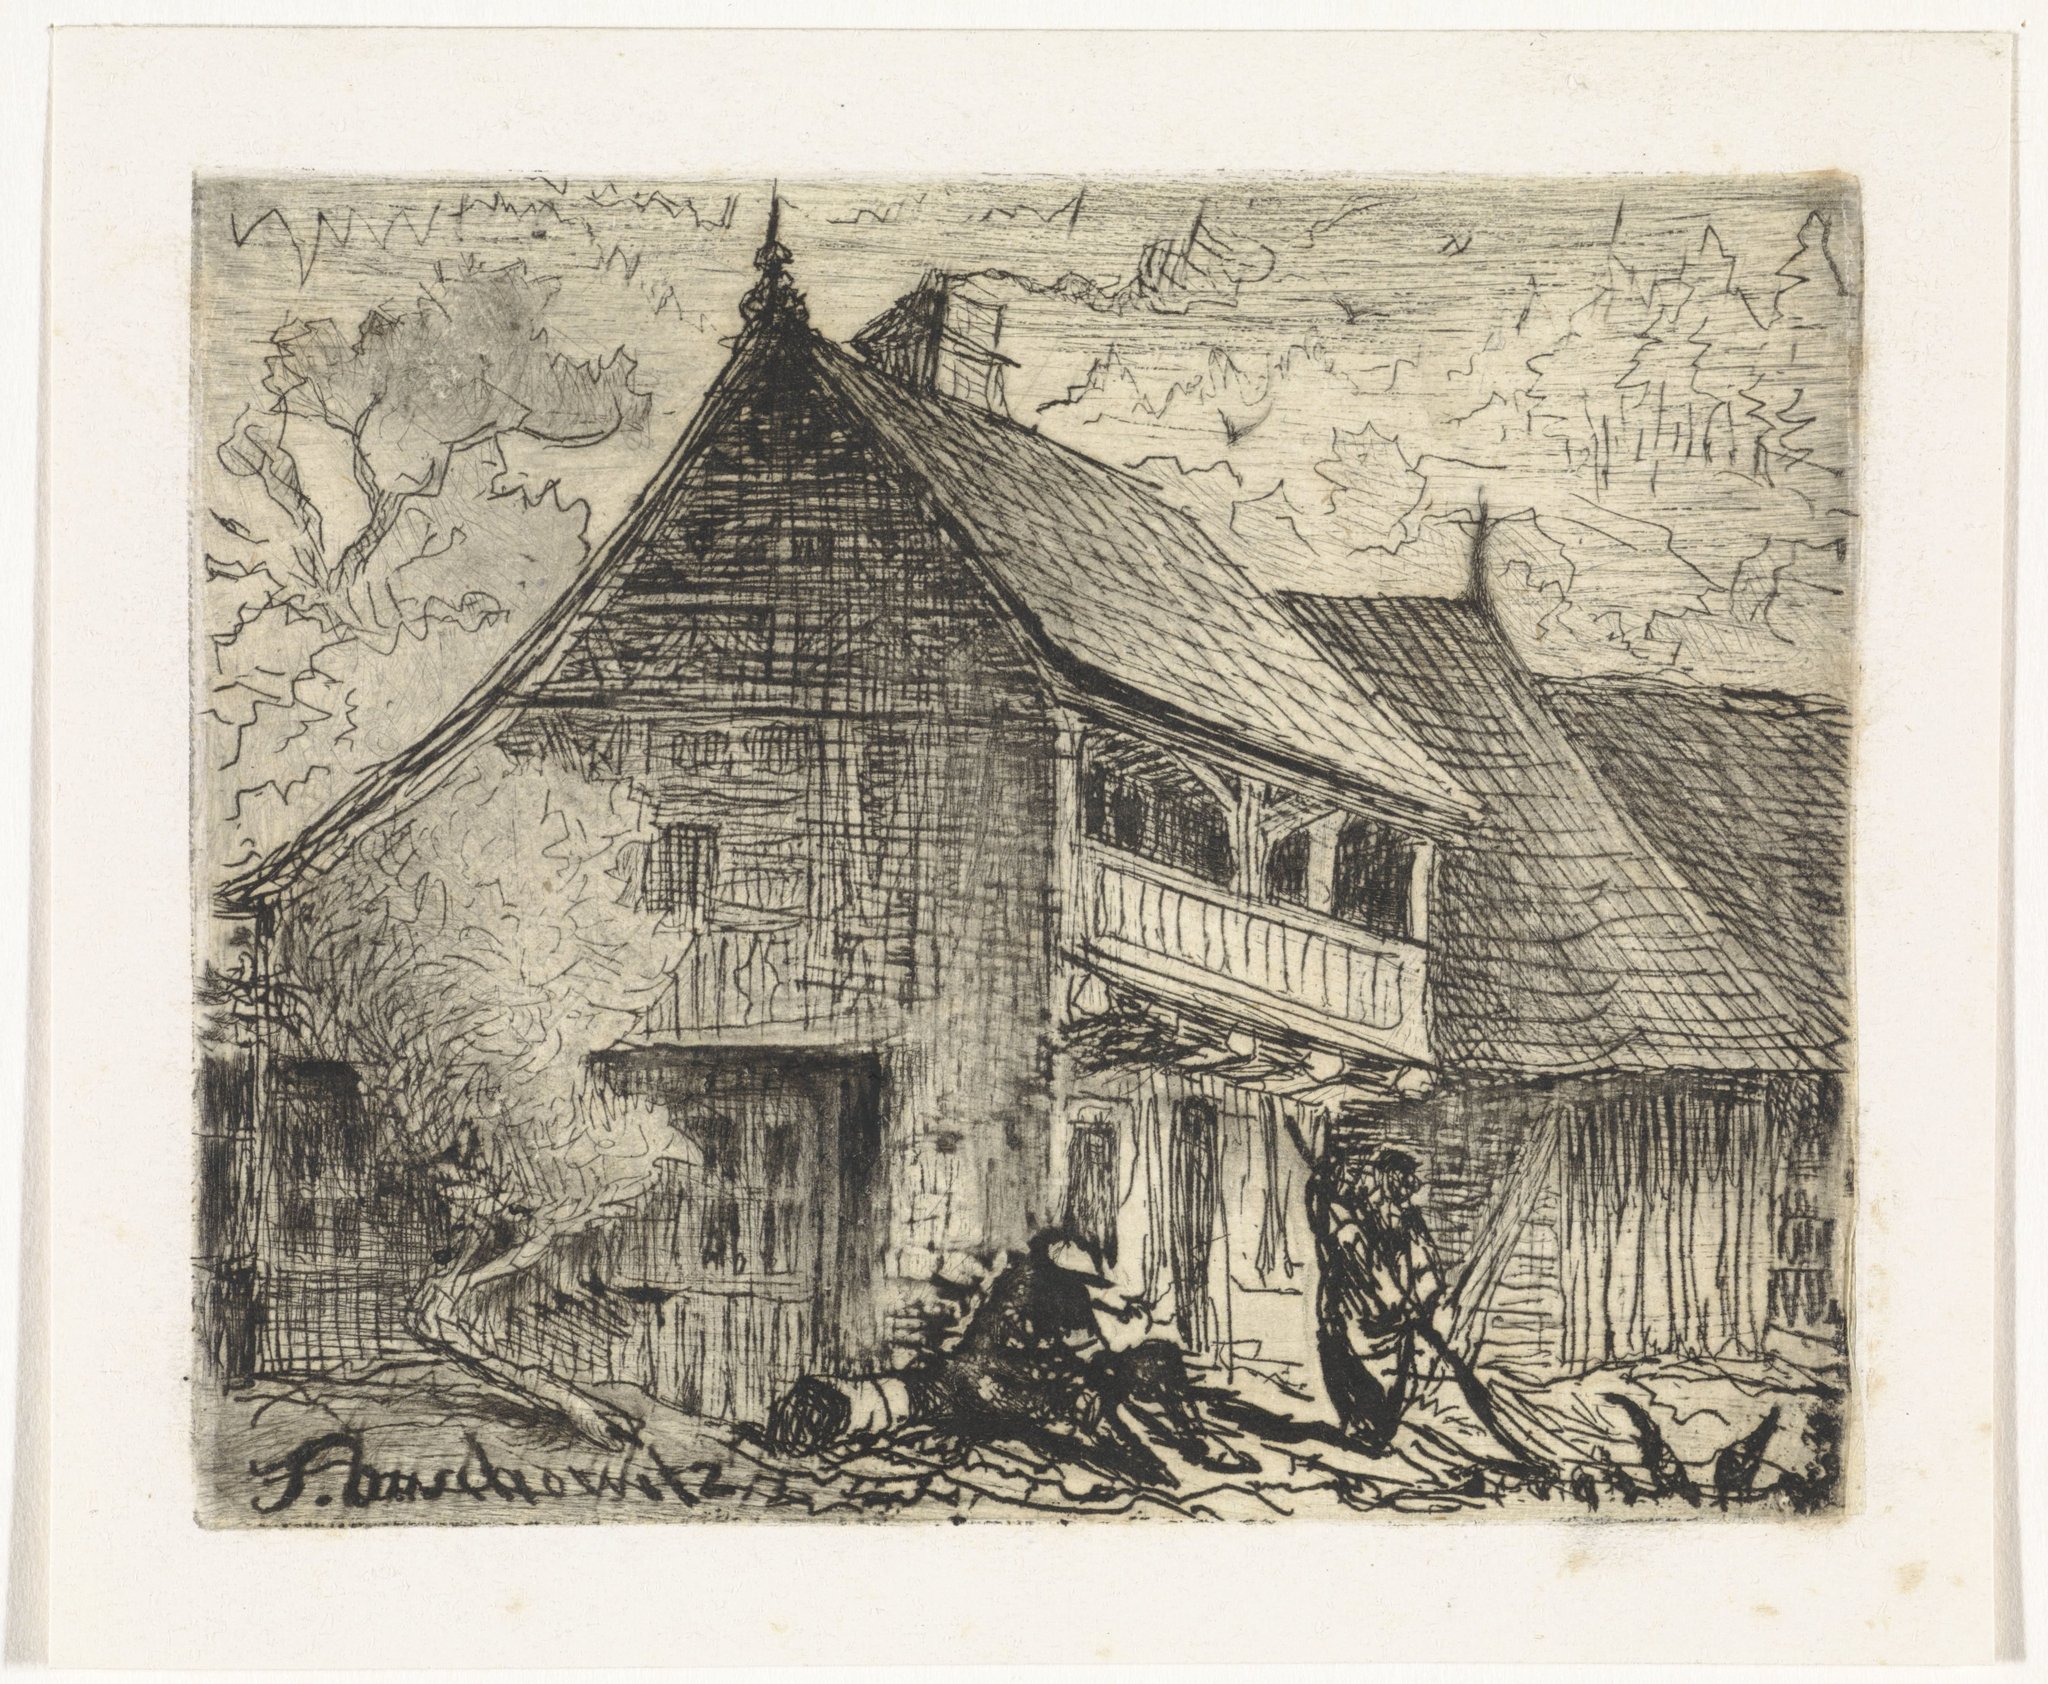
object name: print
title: Huisje te Auschowitz in Bohemen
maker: johannes tavenraat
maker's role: draughtsman, painter, print maker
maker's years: 1809-1881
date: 1819-1881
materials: paper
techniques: drypoint, etching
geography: cleves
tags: village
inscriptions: collector's mark: Lugt 2228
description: Twee mannen voor een huis in Auschowitz in Bohemen.